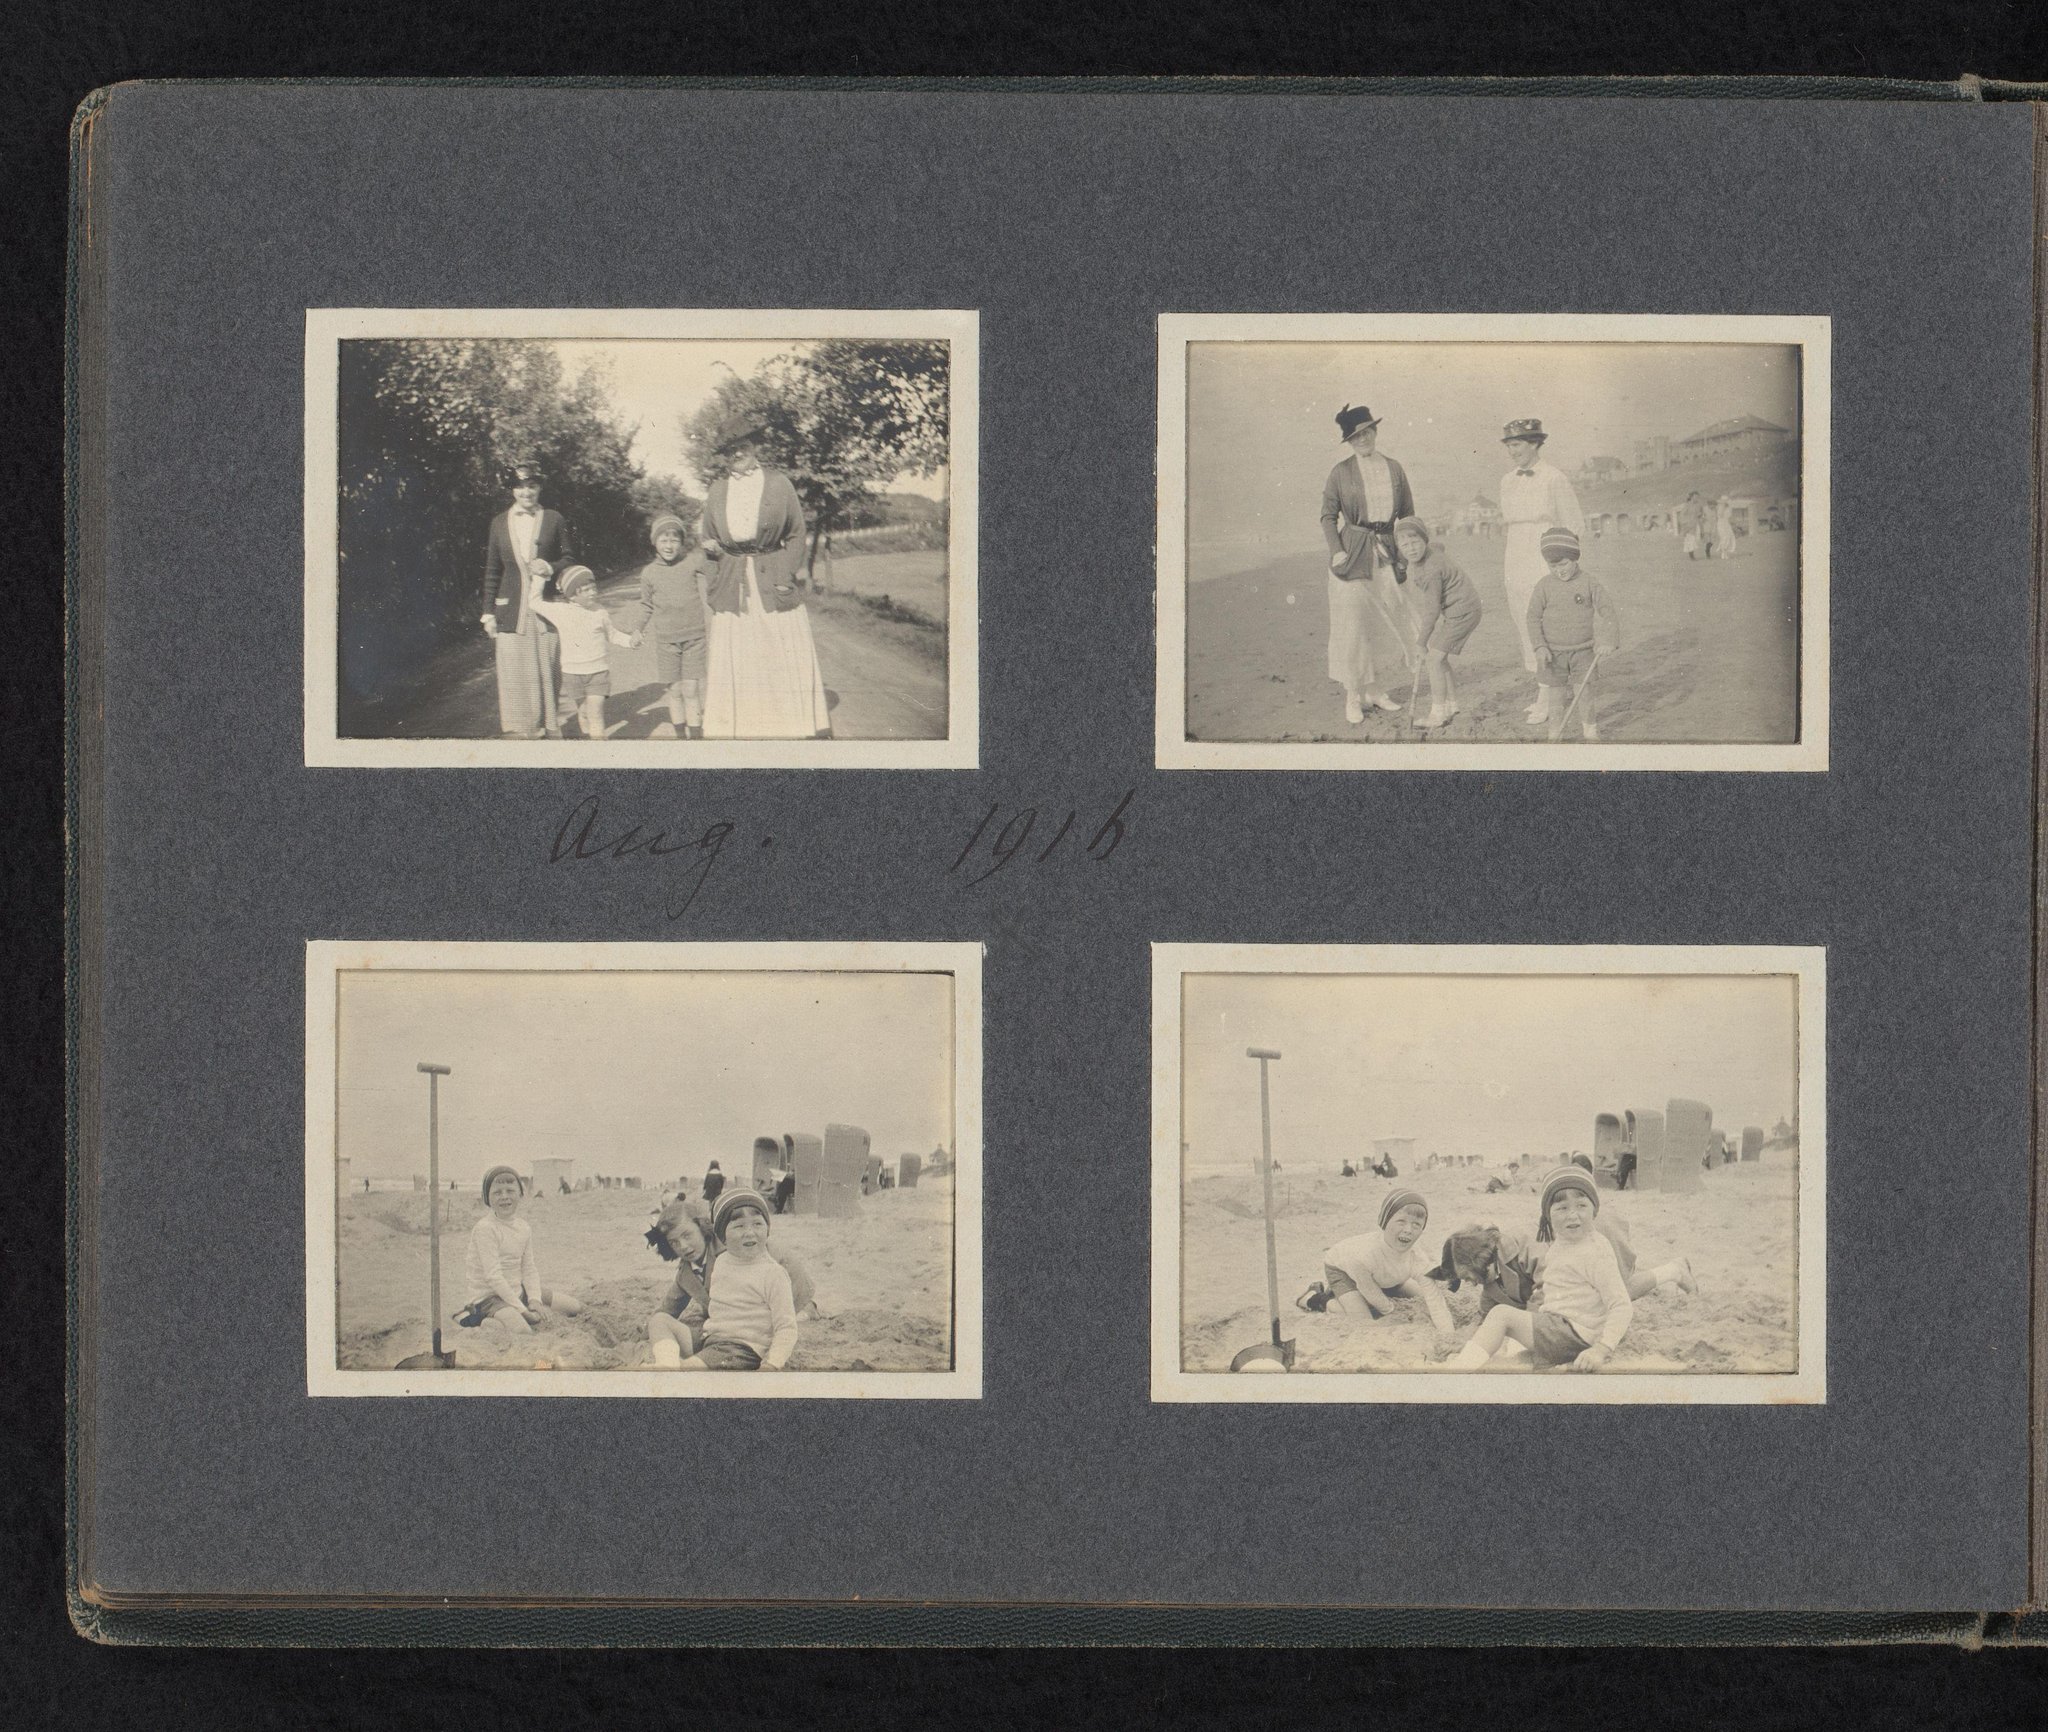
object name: photograph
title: Caroline, Carel en Frank van den Berg op het strand in Noordwijk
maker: hendrik herman van den berg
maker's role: amateurfotograaf, jurist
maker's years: 1875-1944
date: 1908-1916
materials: paper, cardboard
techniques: gelatin silver print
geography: noordwijk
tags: the hague, caroline louise van den berg-van den berg, carel frederik van den berg (cay), amsterdam, frank willem van den berg (1912-1998), beach (as place of recreation)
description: Deze foto's zijn onderdeel van een album.